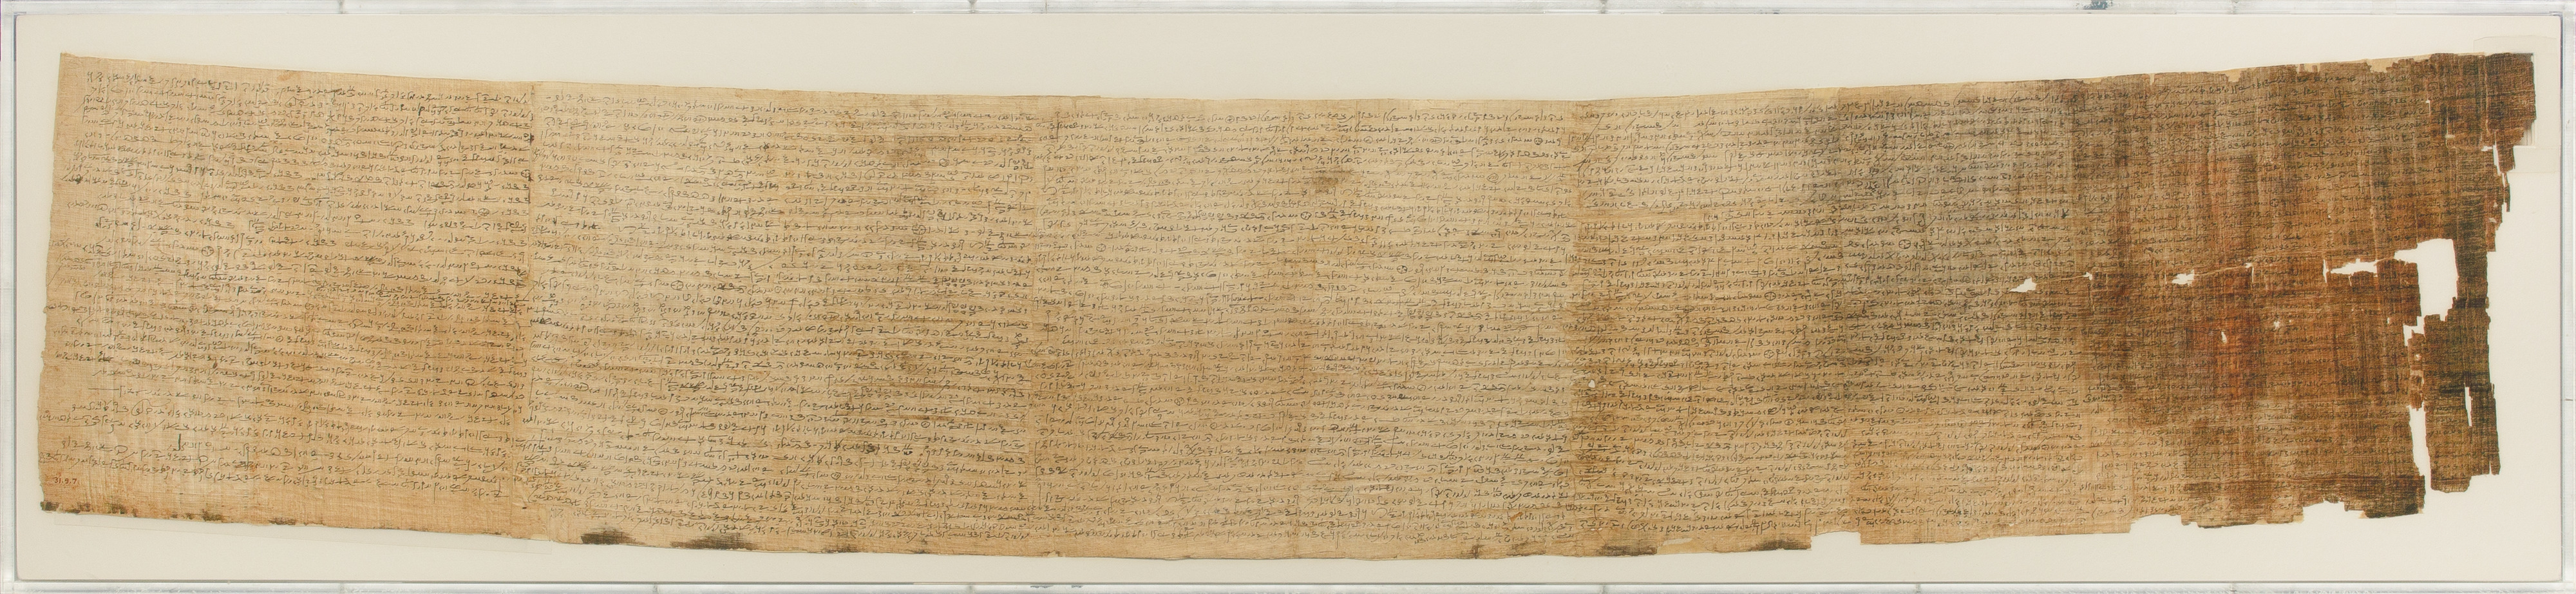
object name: papyrus, religious text, tanaweruow, demotic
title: Religious text of Tanaweruow, daughter of Hartophnakhthes and Tatita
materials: ink, papyrus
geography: northern upper egypt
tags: demotic